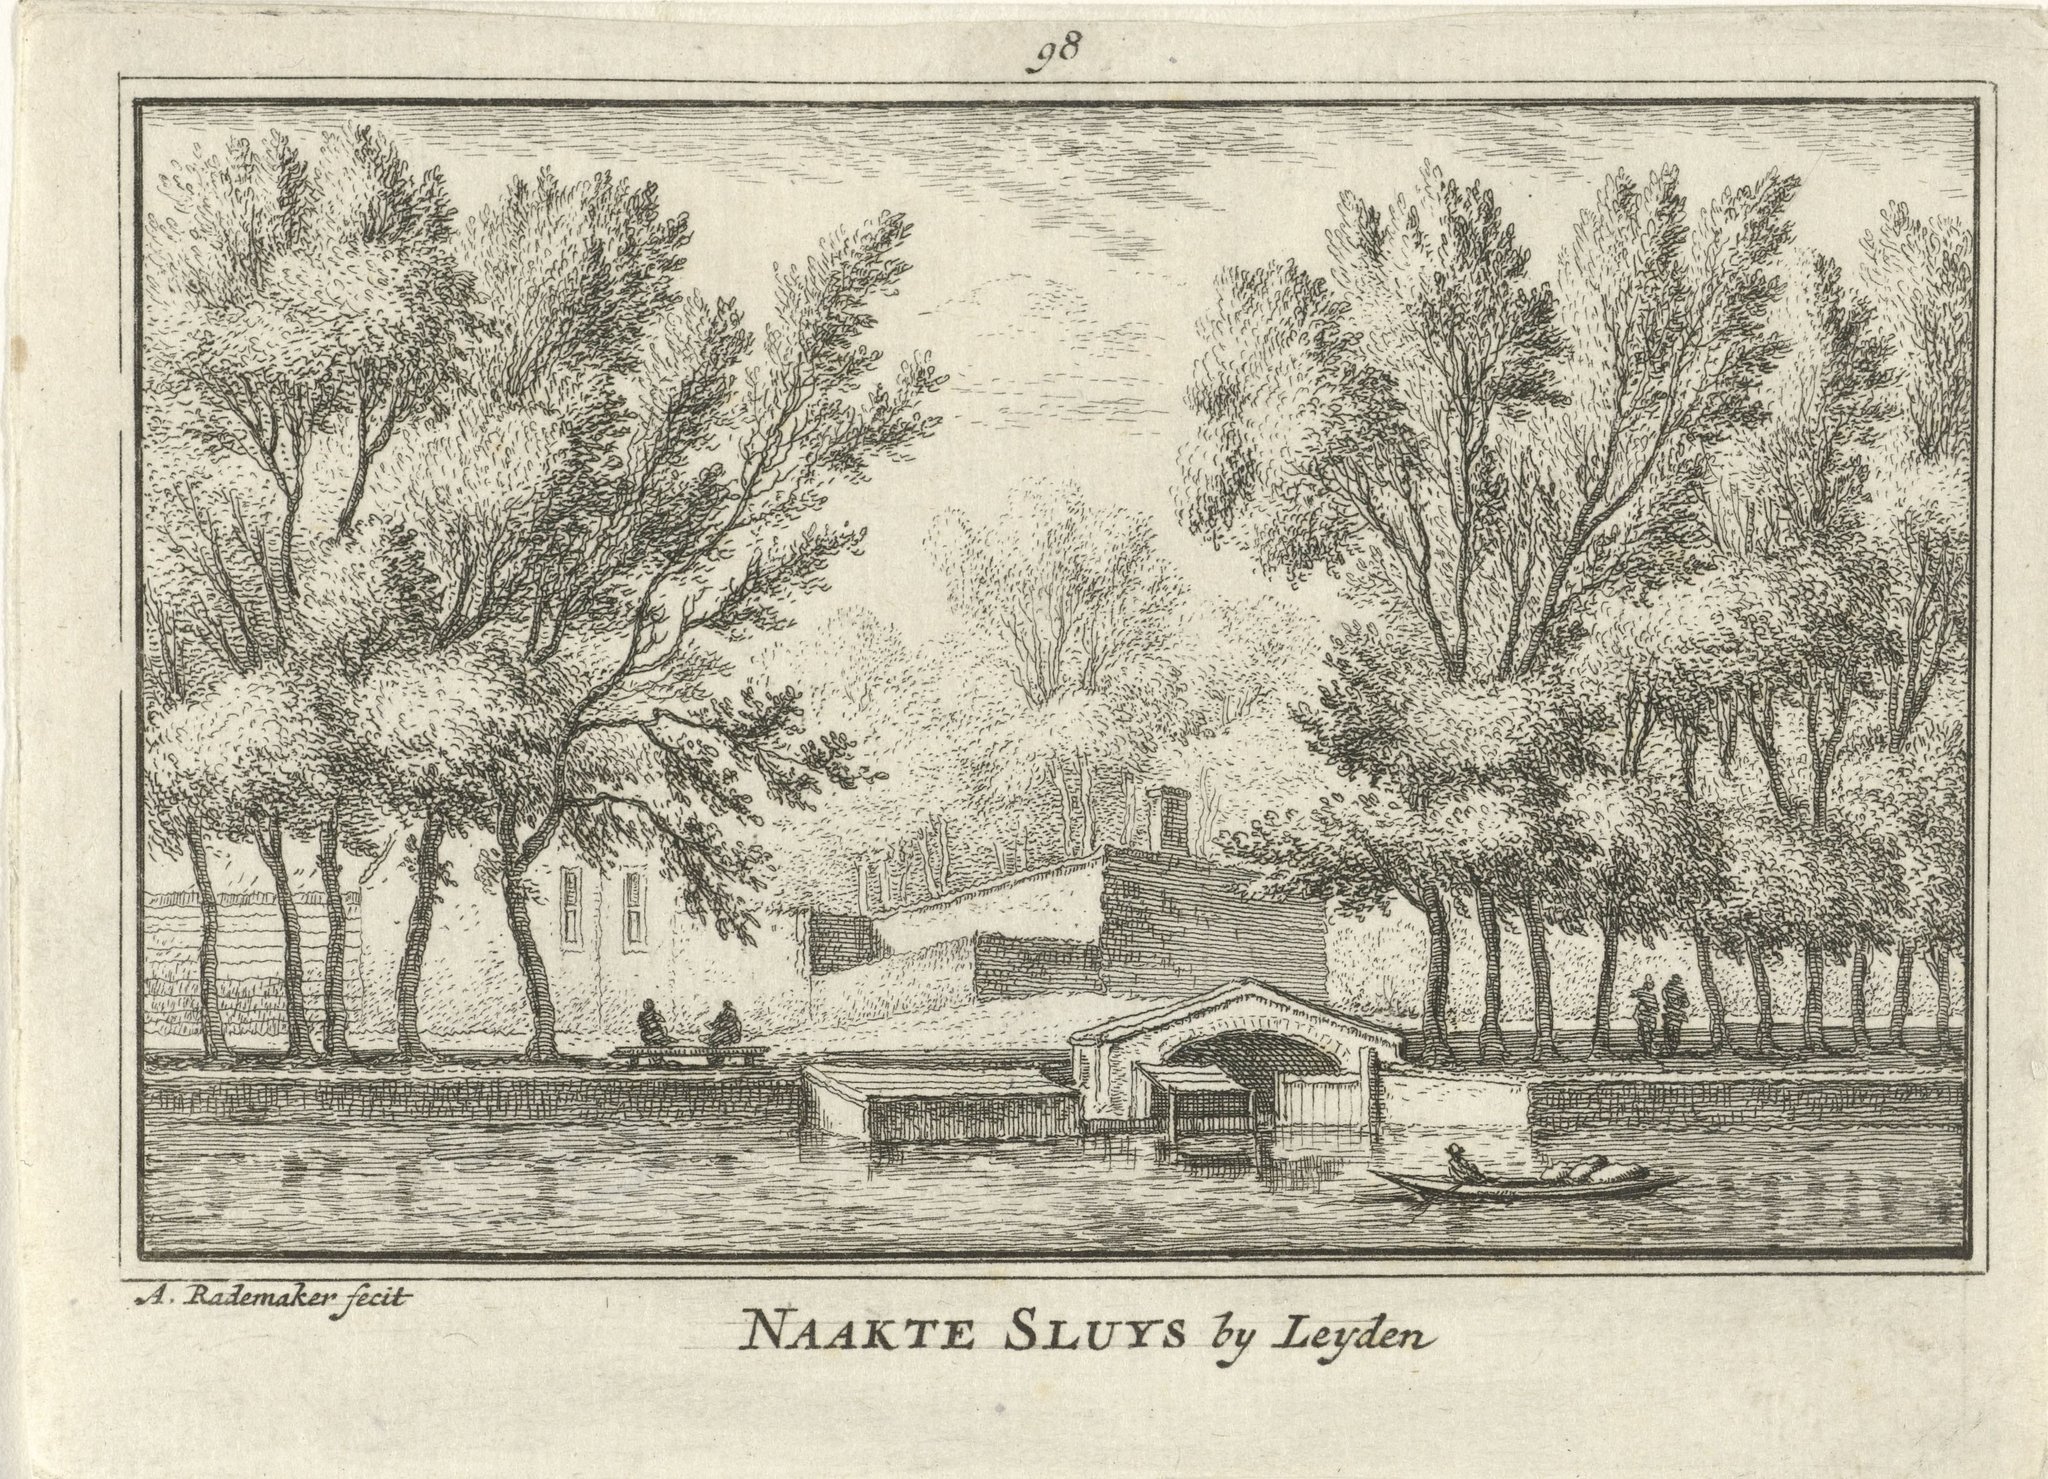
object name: print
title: Naakte Sluys by Leyden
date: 1727-1733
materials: paper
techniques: etching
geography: amsterdam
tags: lift-lock, canal lock, leiden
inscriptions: collector's mark: Lugt 2228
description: Illustratie uit: Abraham Rademaker, Matthaeus Brouërius van Niedek, Isaac Le Long, Kabinet van Nederlandsche en Kleefsche outheden en (...) voorname stads- en landgebouwen, Willem Barents en Antoni Schoonenburg: Amsterdam, 1727-1733, ill. nr. 98.